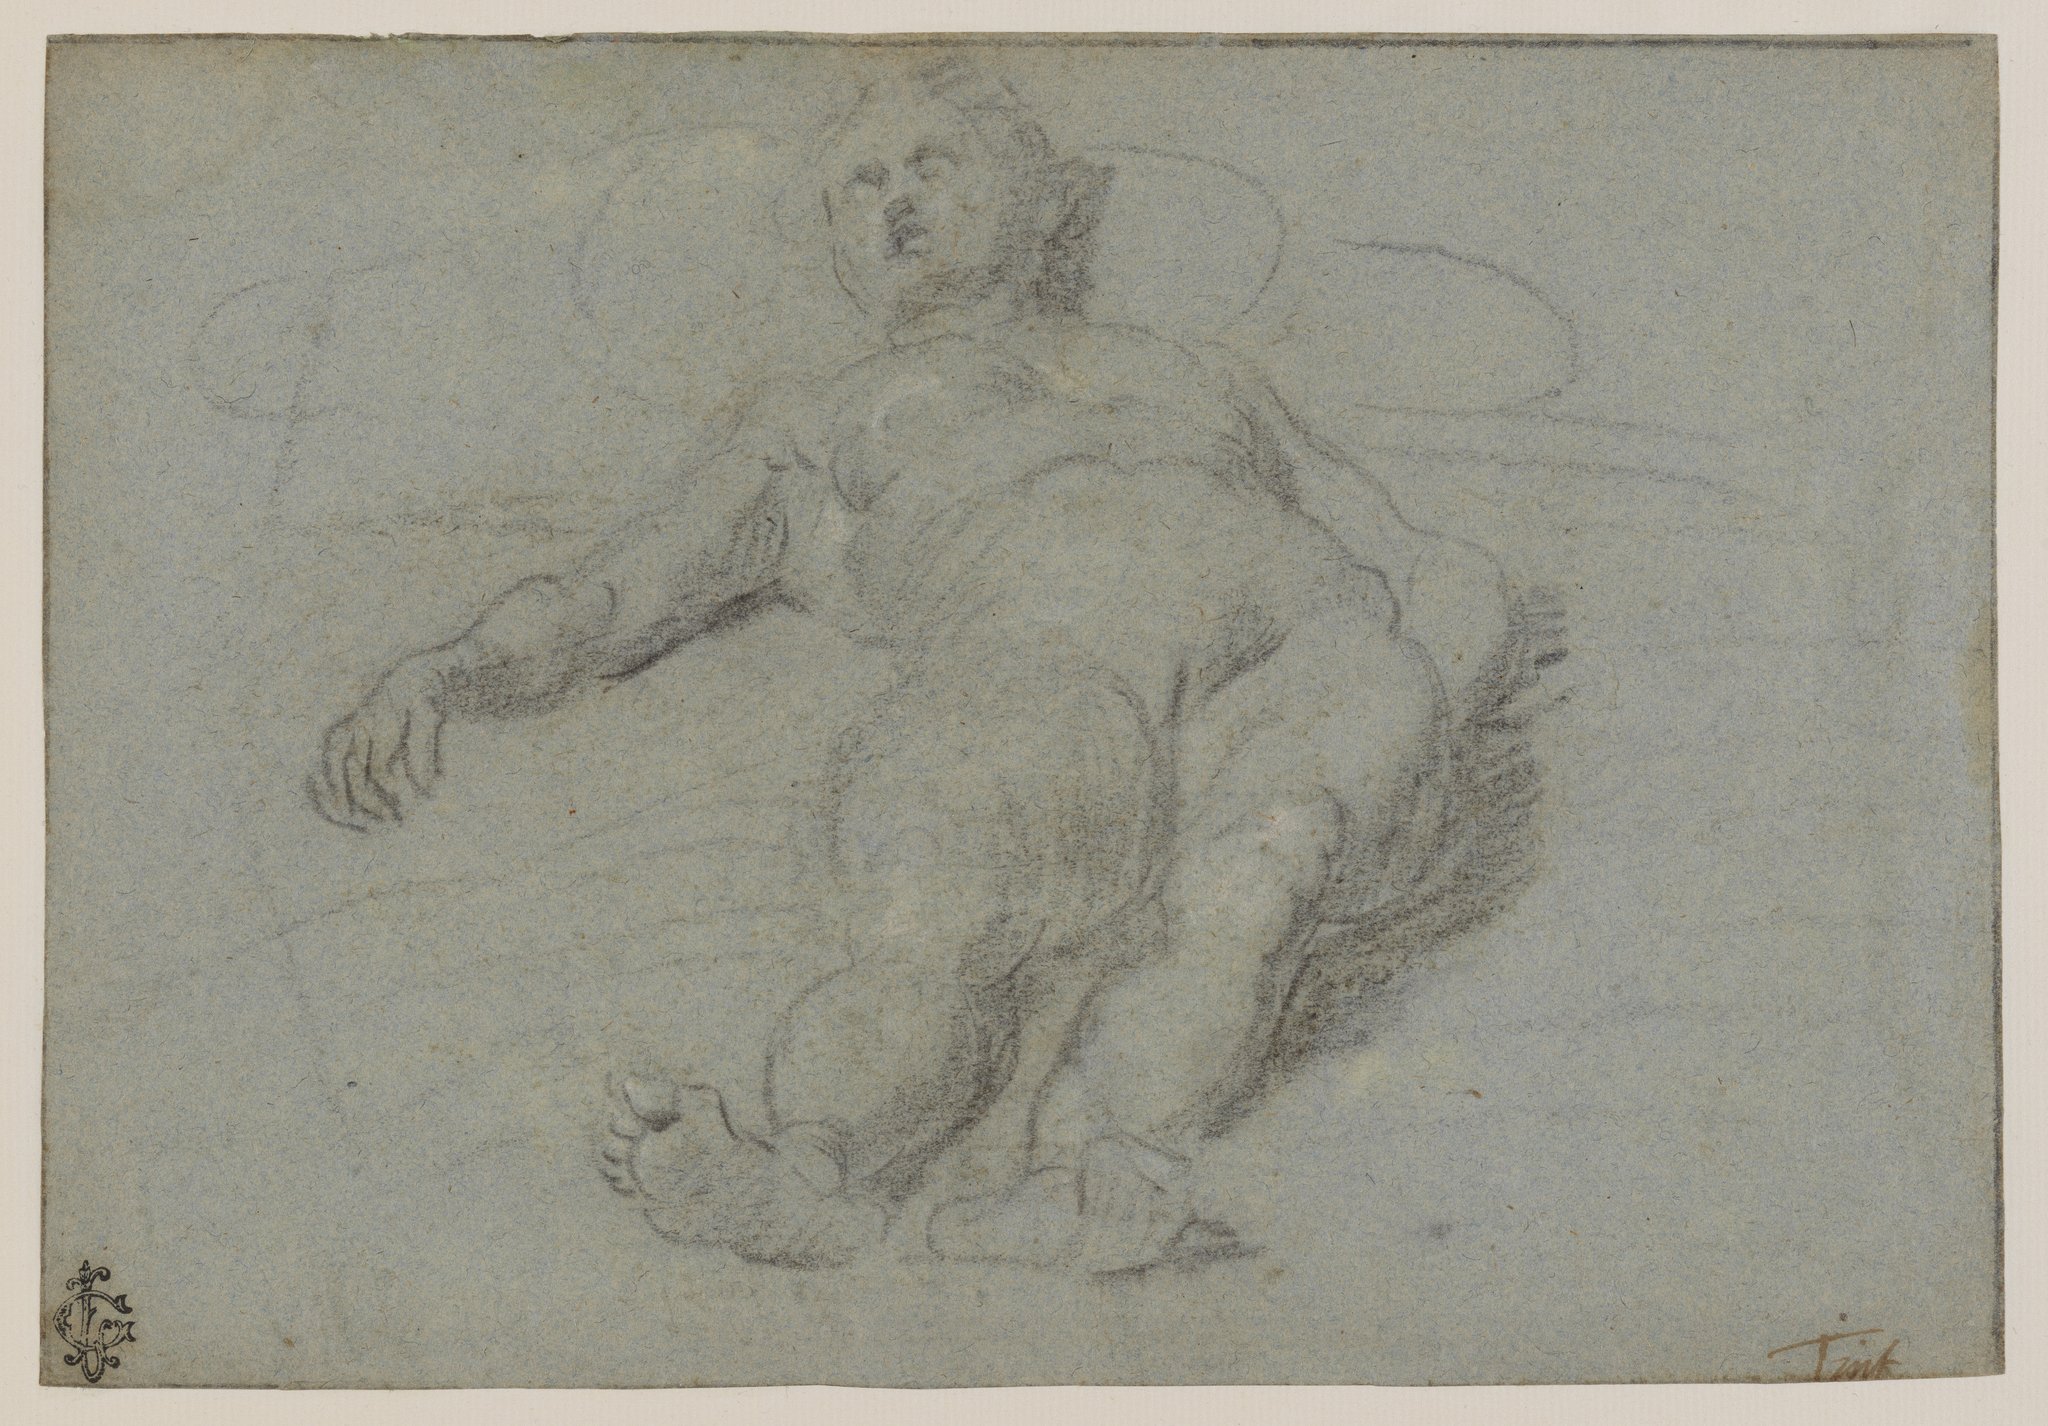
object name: drawing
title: Reclining Female Nude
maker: domenico tintoretto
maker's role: artist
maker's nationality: italian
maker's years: 1560-1635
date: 1601-1633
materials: chalk, paper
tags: female nudes